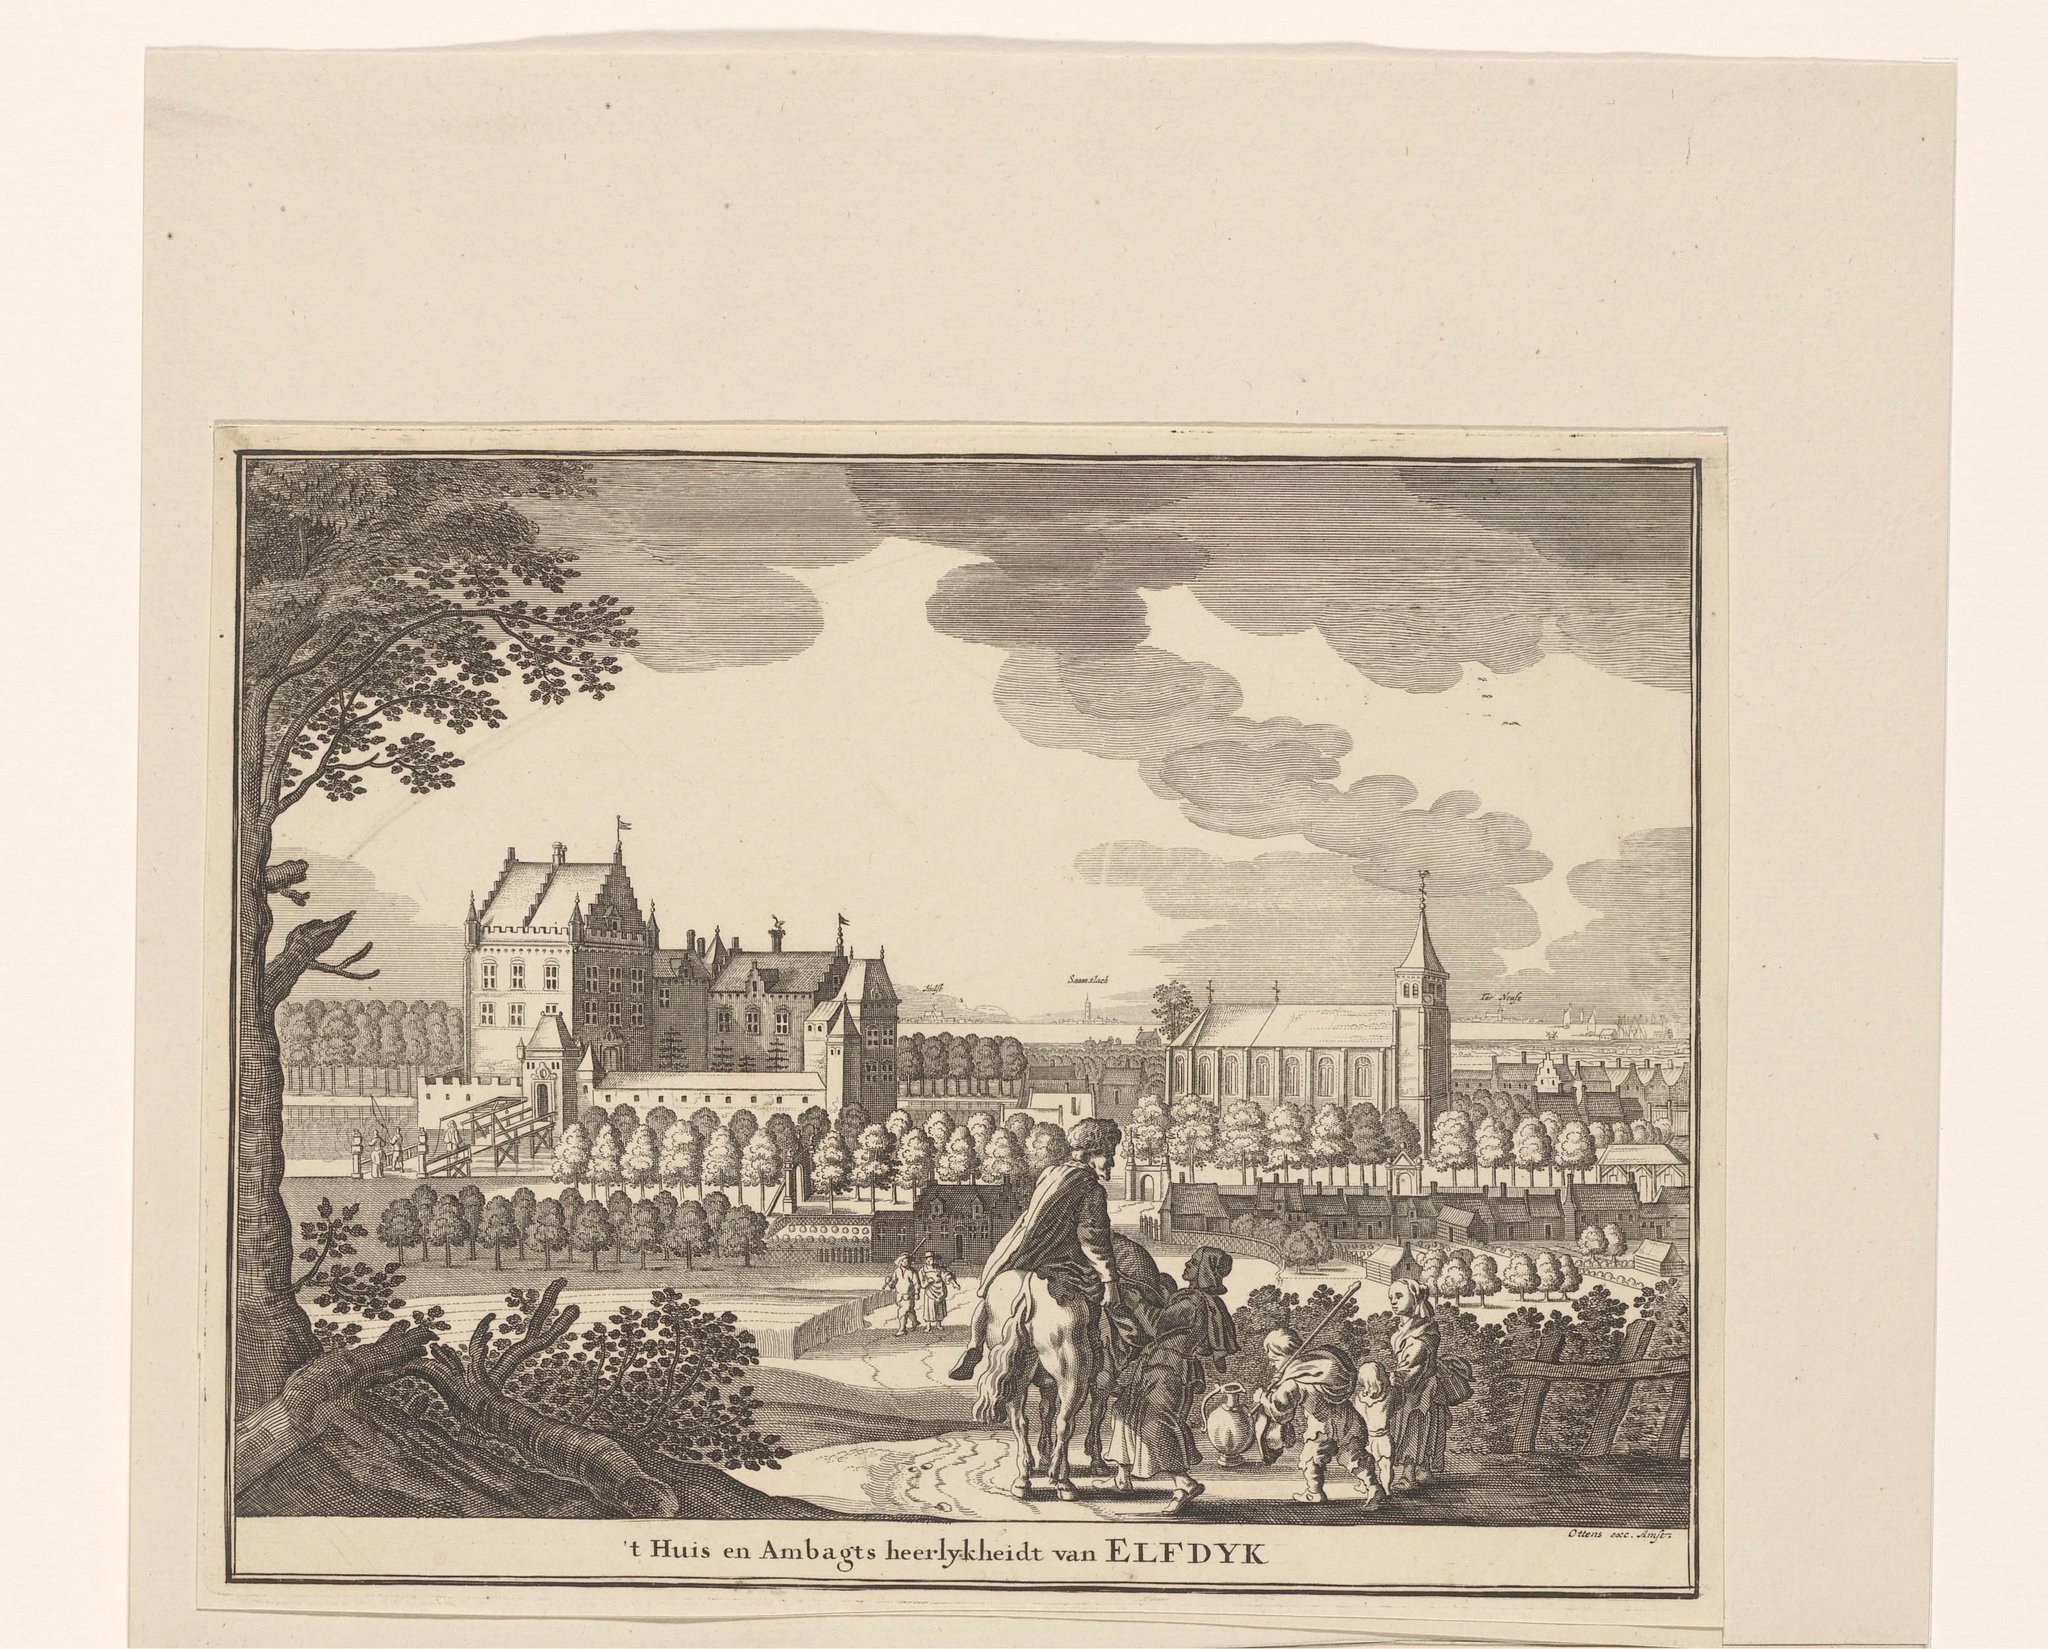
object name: print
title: Gezicht op Ellewoutsdijk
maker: pieter hendricksz. schut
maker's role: print maker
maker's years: 1618-1660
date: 1657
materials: paper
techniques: engraving, etching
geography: amsterdam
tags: prospect of village, silhouette of village, castle, church (exterior), prospect of city, town panorama, silhouette of city, ellewoutsdijk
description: Prent ook gebruikt in: Speculum Zelandiae dat is een beschryvinge ofte afbeelding der steden, ambachts-heerlijckheden, dorpen castelen, ridderlijcke hofsteden, huysen en gebouwen gelegen inde eylanden en de graeflijckheyt van Zeelandt. Amsterdam: weduwe Ottens en Zoonen, s.a. [1719-1725]. Eerdere staat/staten van prent is/zijn gebruikt in eerdere uitgaven van 'Speculum Zelandiae' en in andere publicaties uitgegeven door Zacharias Roman en Nicolaes Visscher (I). De eerste publicatie waarin de eerste staat van de huidige prent voorkomt dateert uit 1657. Verwarring rondom de datering kan ontstaan door het feit de prenten uit 'Speculum Zelandiae' ook voorkomen in eerder uitgegeven publicaties, waar ze later in zijn ingebonden. Zo komen prenten uitgegeven door Roman/Visscher voor in sommige exemplaren van: Boxhorn, Marcus Zuerius van. Chroniick van Zeelandt (…). 2 delen. Middelburg: Zacharias Roman, 1644. De door weduwe (Joachim) Ottens en Zoonen uitgegeven prenten zijn later ingebonden in sommige exemplaren van: Smallegange, Mattheus. Nieuwe Cronyk van Zeeland (…). Middelburg en Amsterdam: Johannes Meertens en Abraham van Someren, 1696.